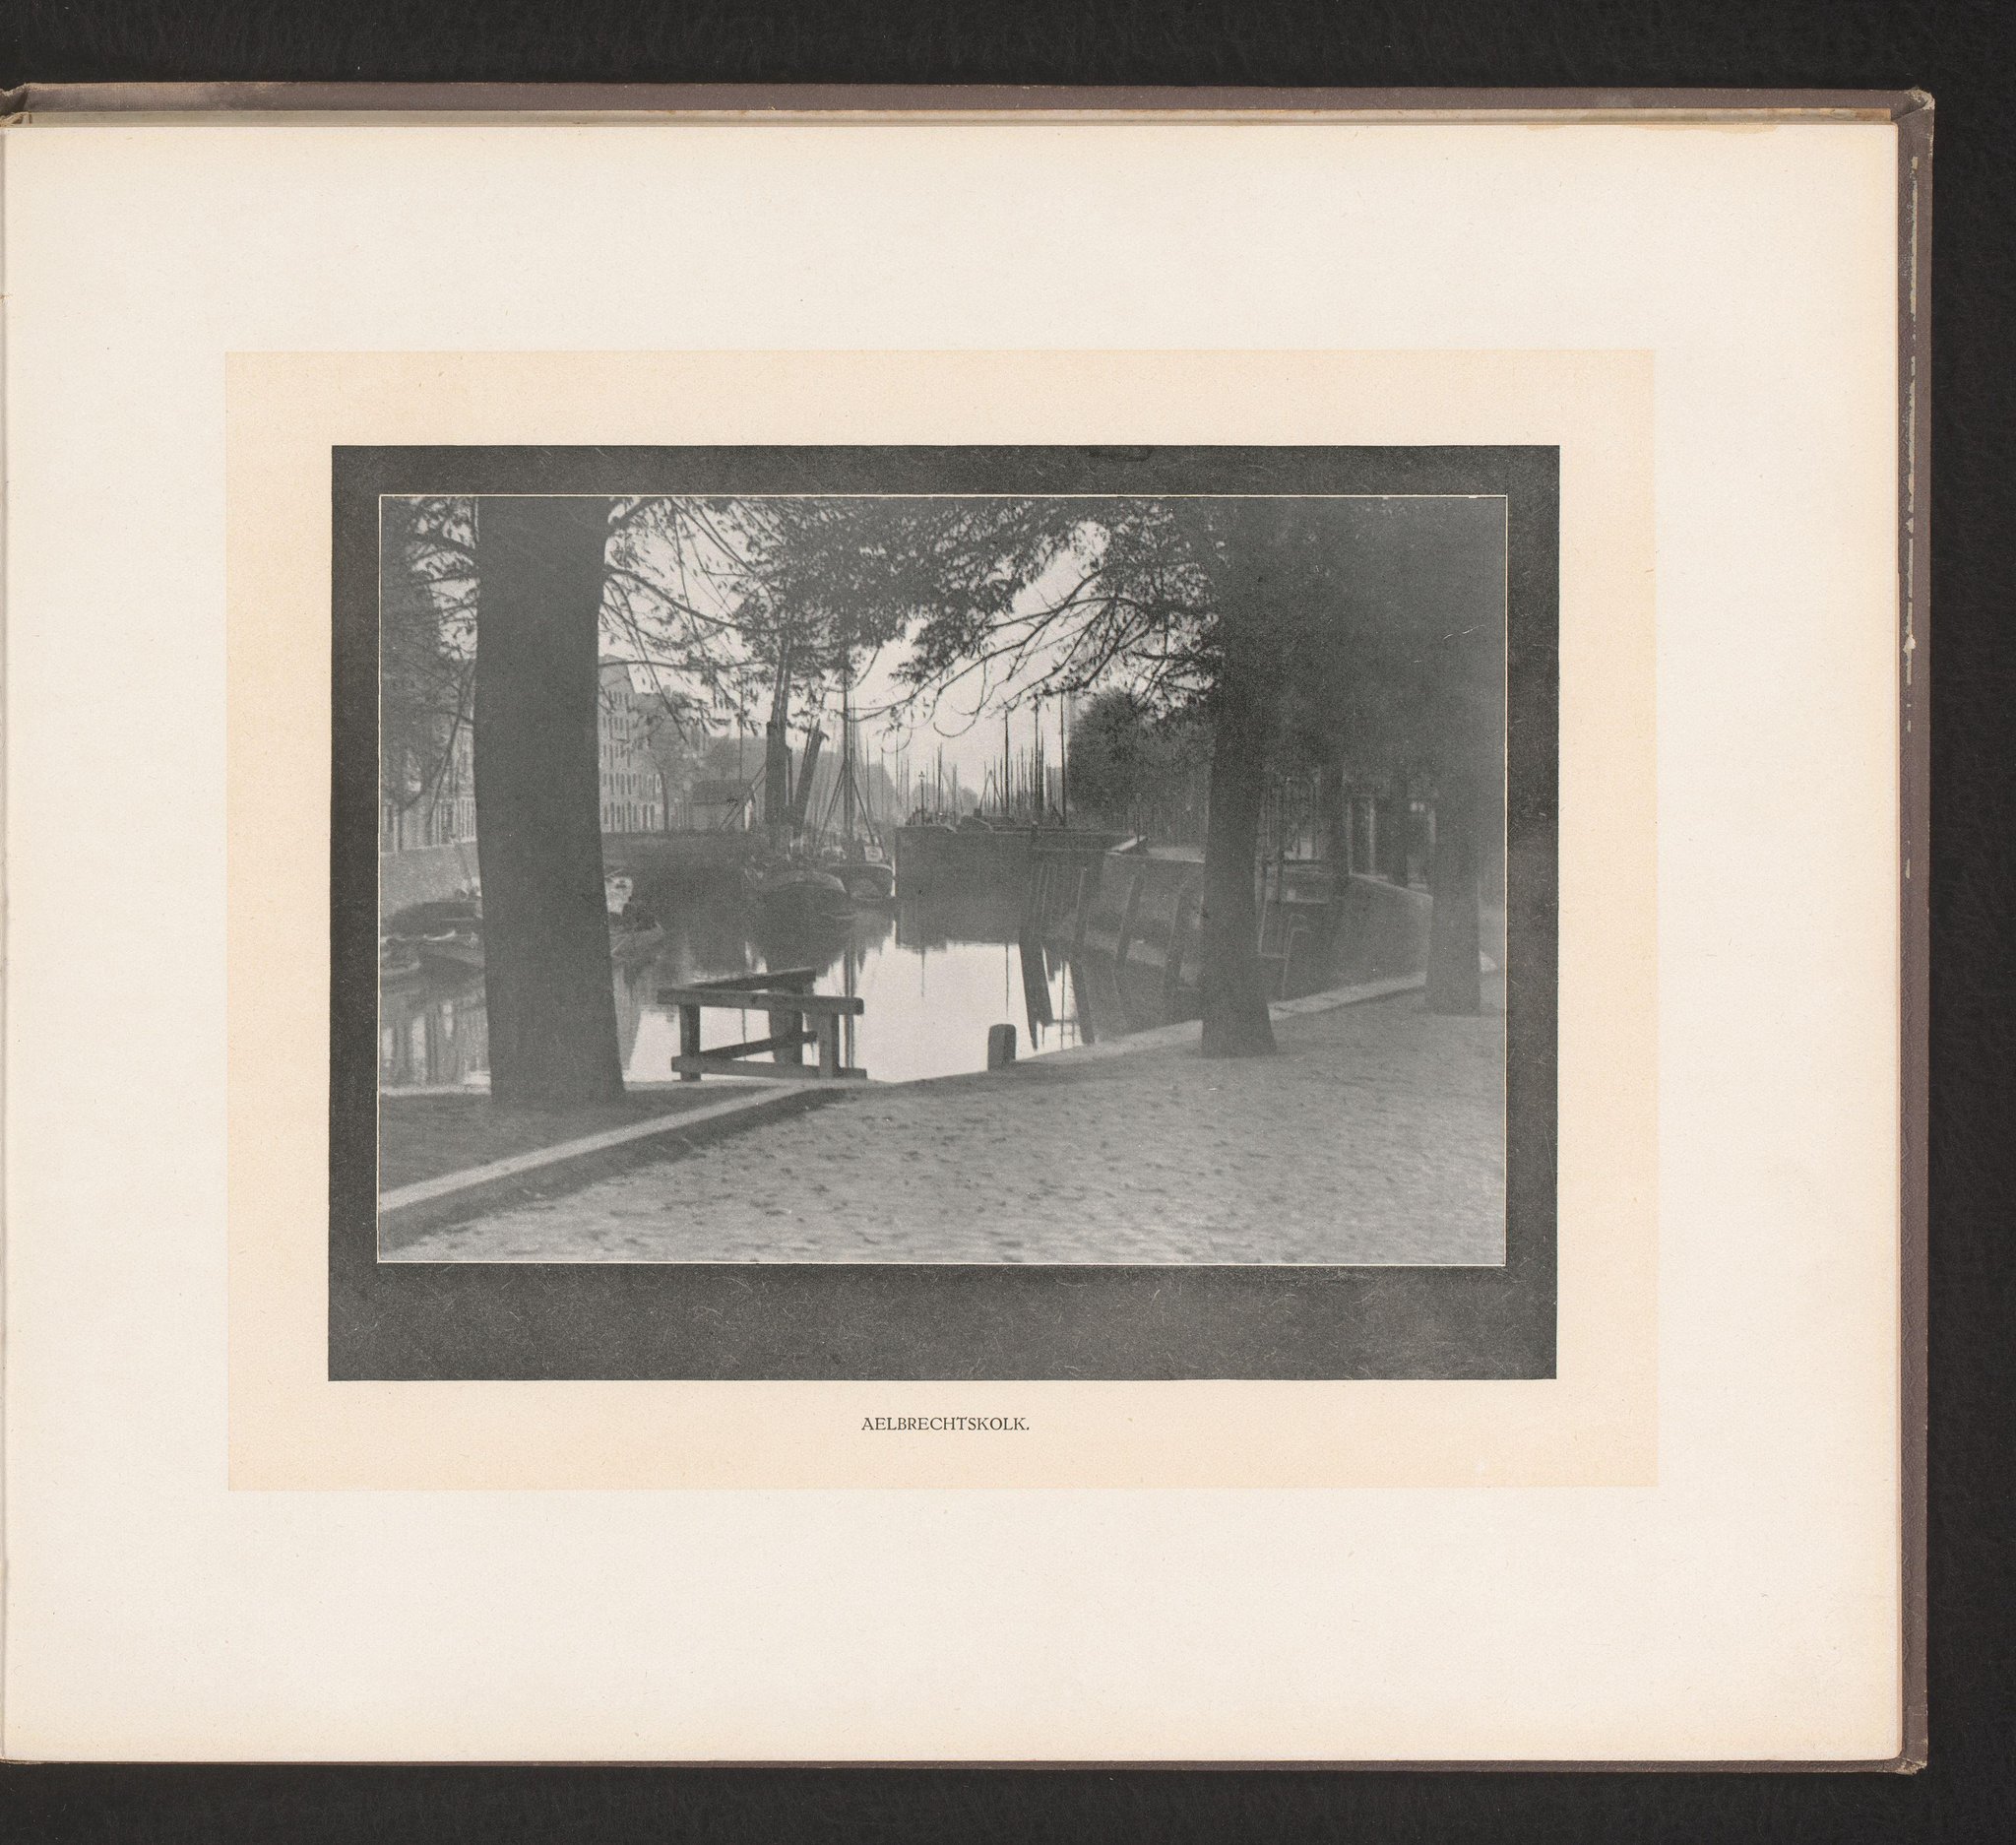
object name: album leaf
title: Gezicht op de Aelbrechtskolk te Rotterdam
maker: Anonymous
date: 1908-1913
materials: paper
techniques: autotype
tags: canals, waters (in city) (+ city(-scape) with figures, staffage), street (+ city(-scape) with figures, staffage), rotterdam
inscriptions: inscription: ‘Aelbrechtskolk.’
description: Deze prent maakt deel uit van een album.